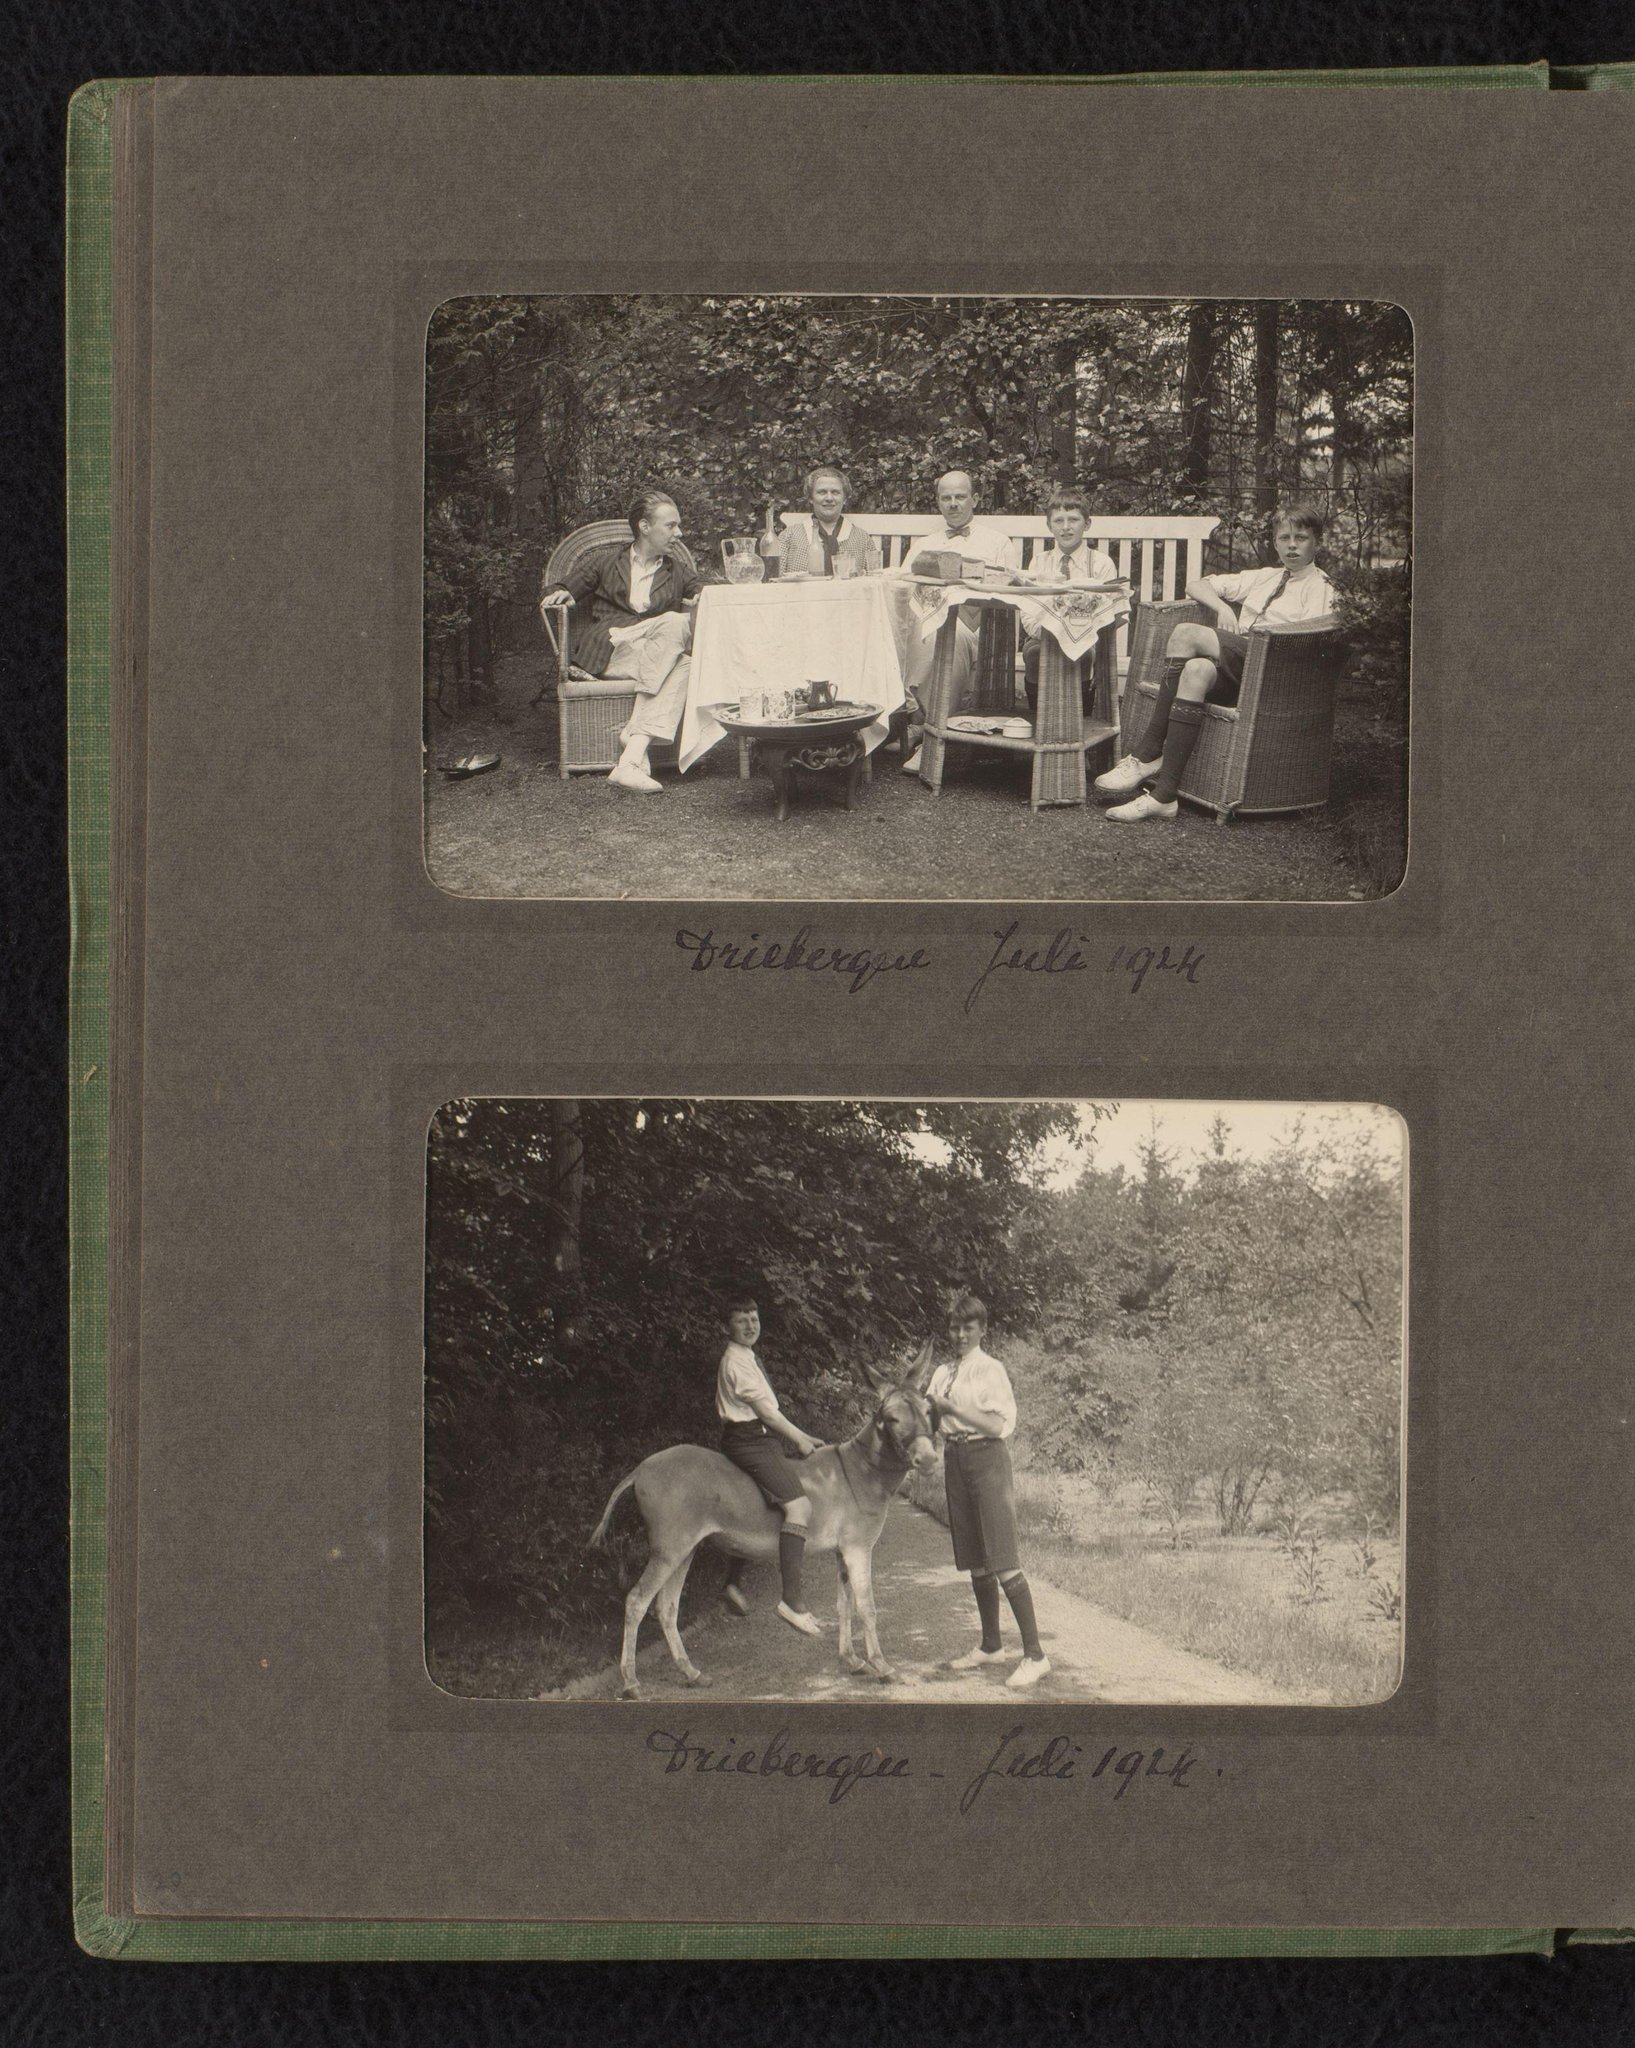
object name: photograph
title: Twee foto's van de familie Van den Berg bij Huize Welgelegen, Driebergen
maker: hendrik herman van den berg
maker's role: amateurfotograaf, jurist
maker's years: 1875-1944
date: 1907-1924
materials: paper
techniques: gelatin silver print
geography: driebergen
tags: hendrik herman van den berg, caroline louise van den berg-van den berg, amsterdam, carel frederik van den berg (cay), frank willem van den berg (1912-1998), midday meal, lunch - cc - out of doors, ass, donkey, family group, especially parents with their child(ren)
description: Deze foto's maken deel uit van een album.